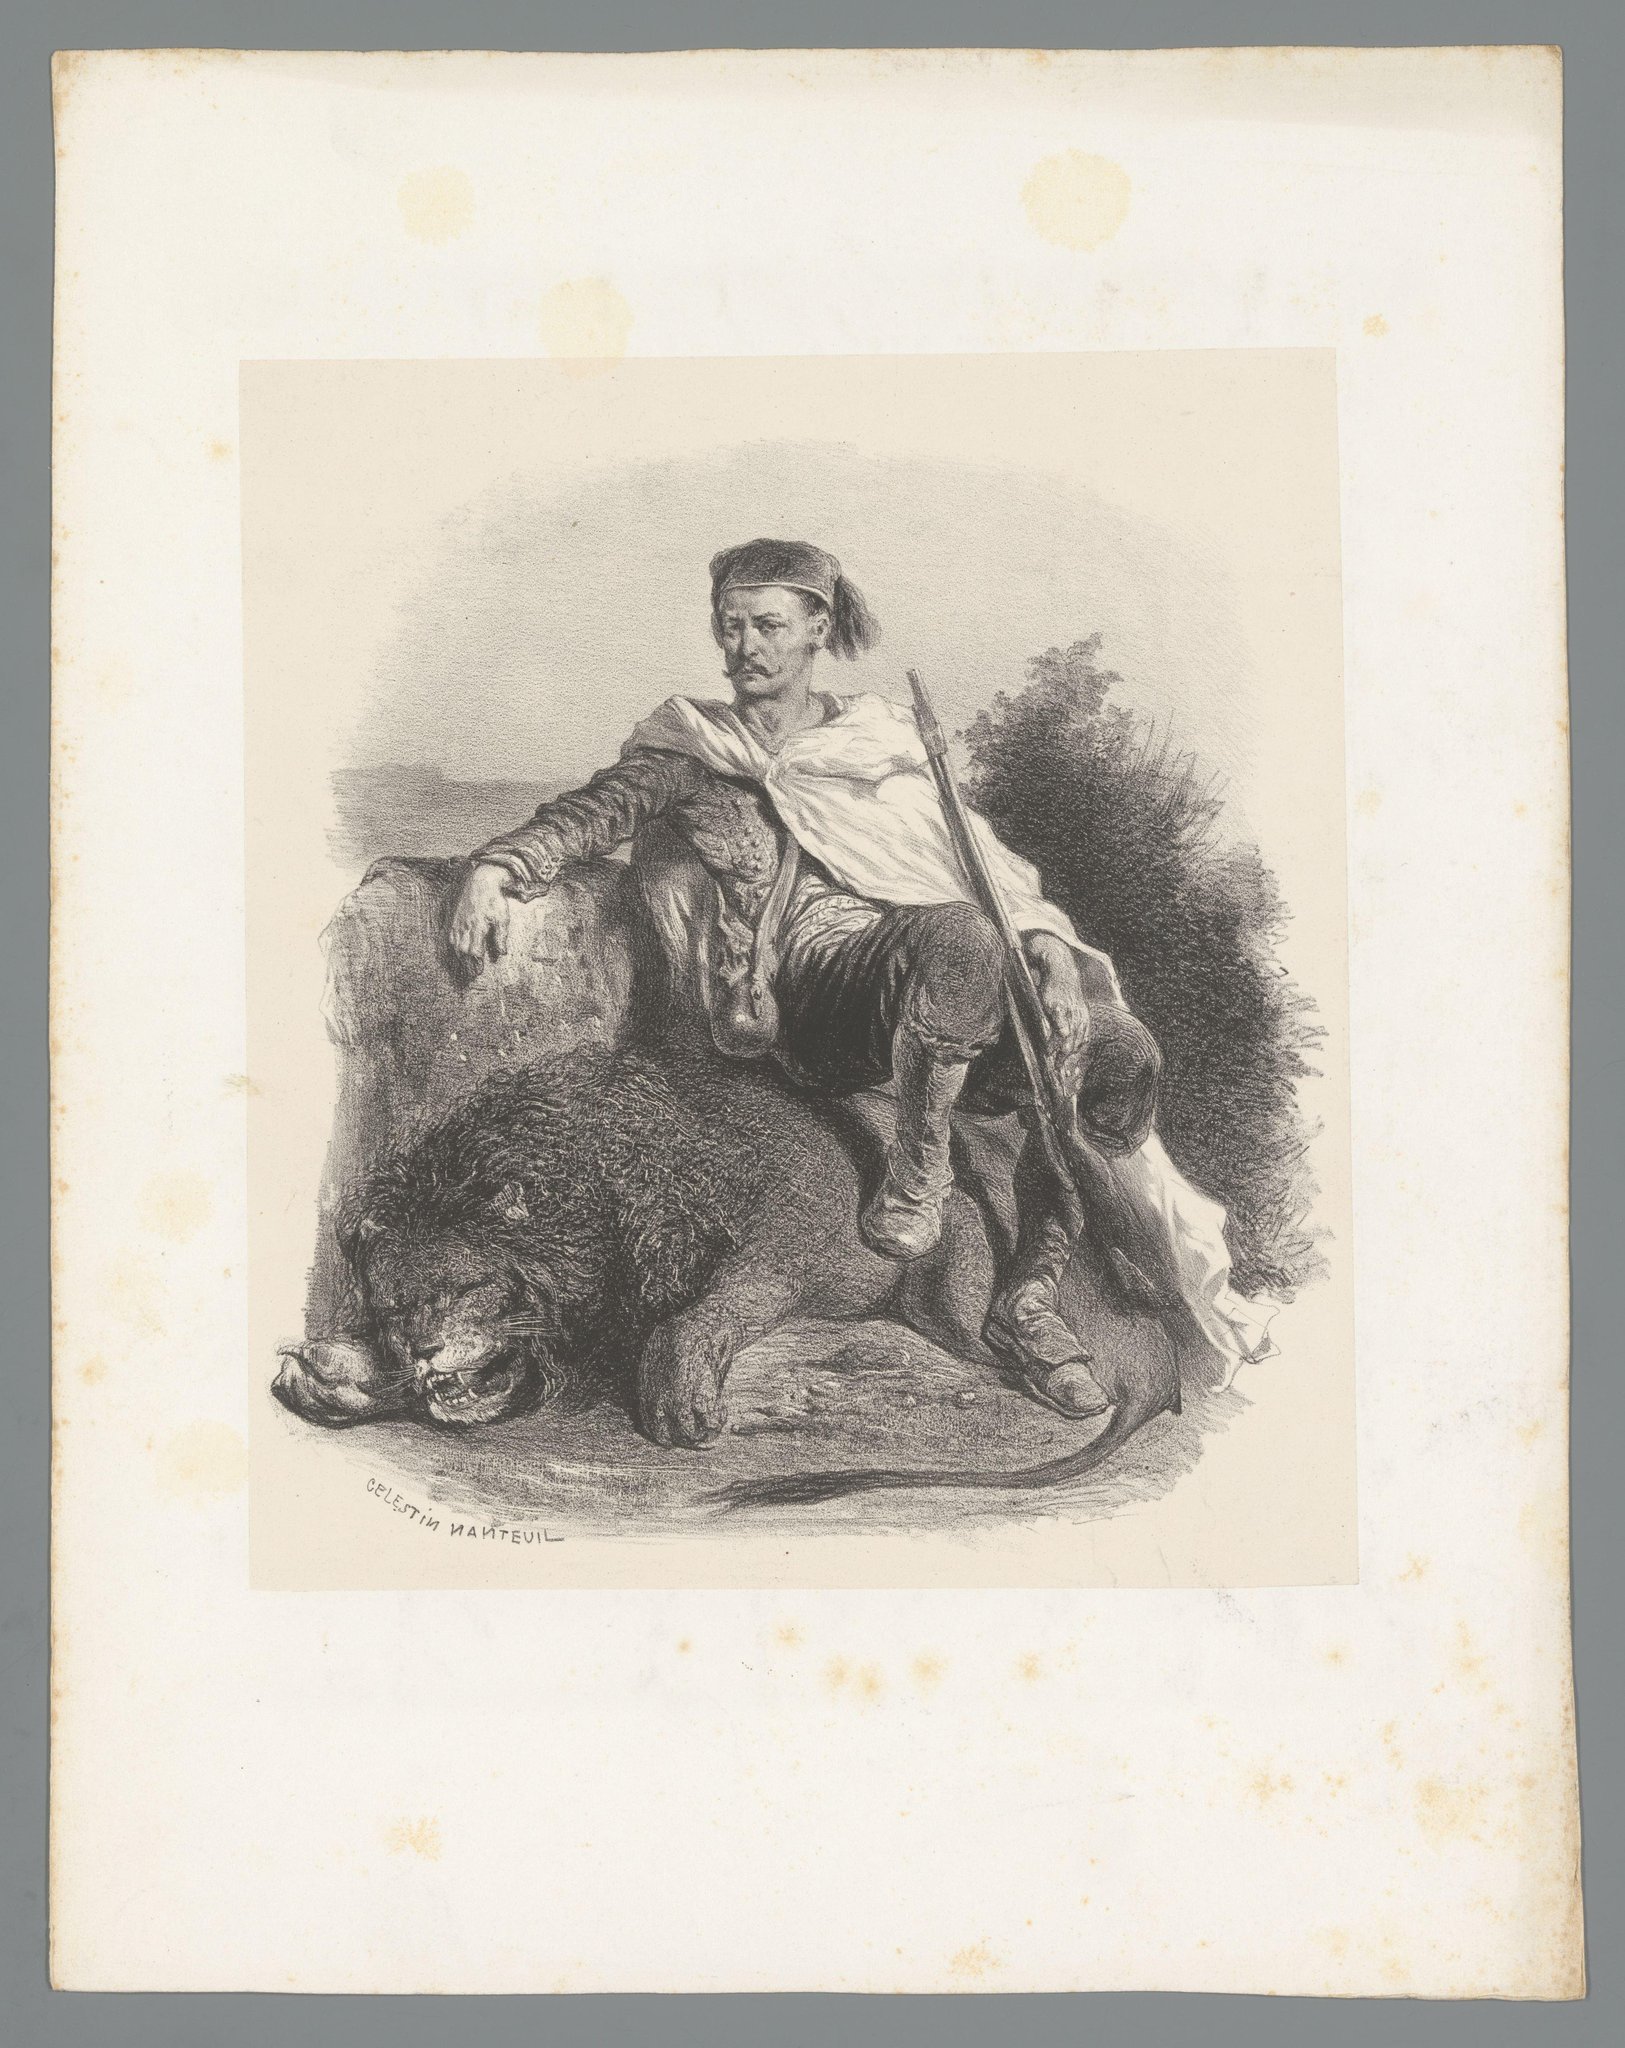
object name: print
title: Man met geweer zit op dode leeuw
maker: célestin françois nanteuil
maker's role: print maker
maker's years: 1813-1873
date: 1823-1873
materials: paper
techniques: lithograph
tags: lion hunt, hunter, firearms: rifle, beasts of prey, predatory animals: lion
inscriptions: collector's mark: Lugt 964